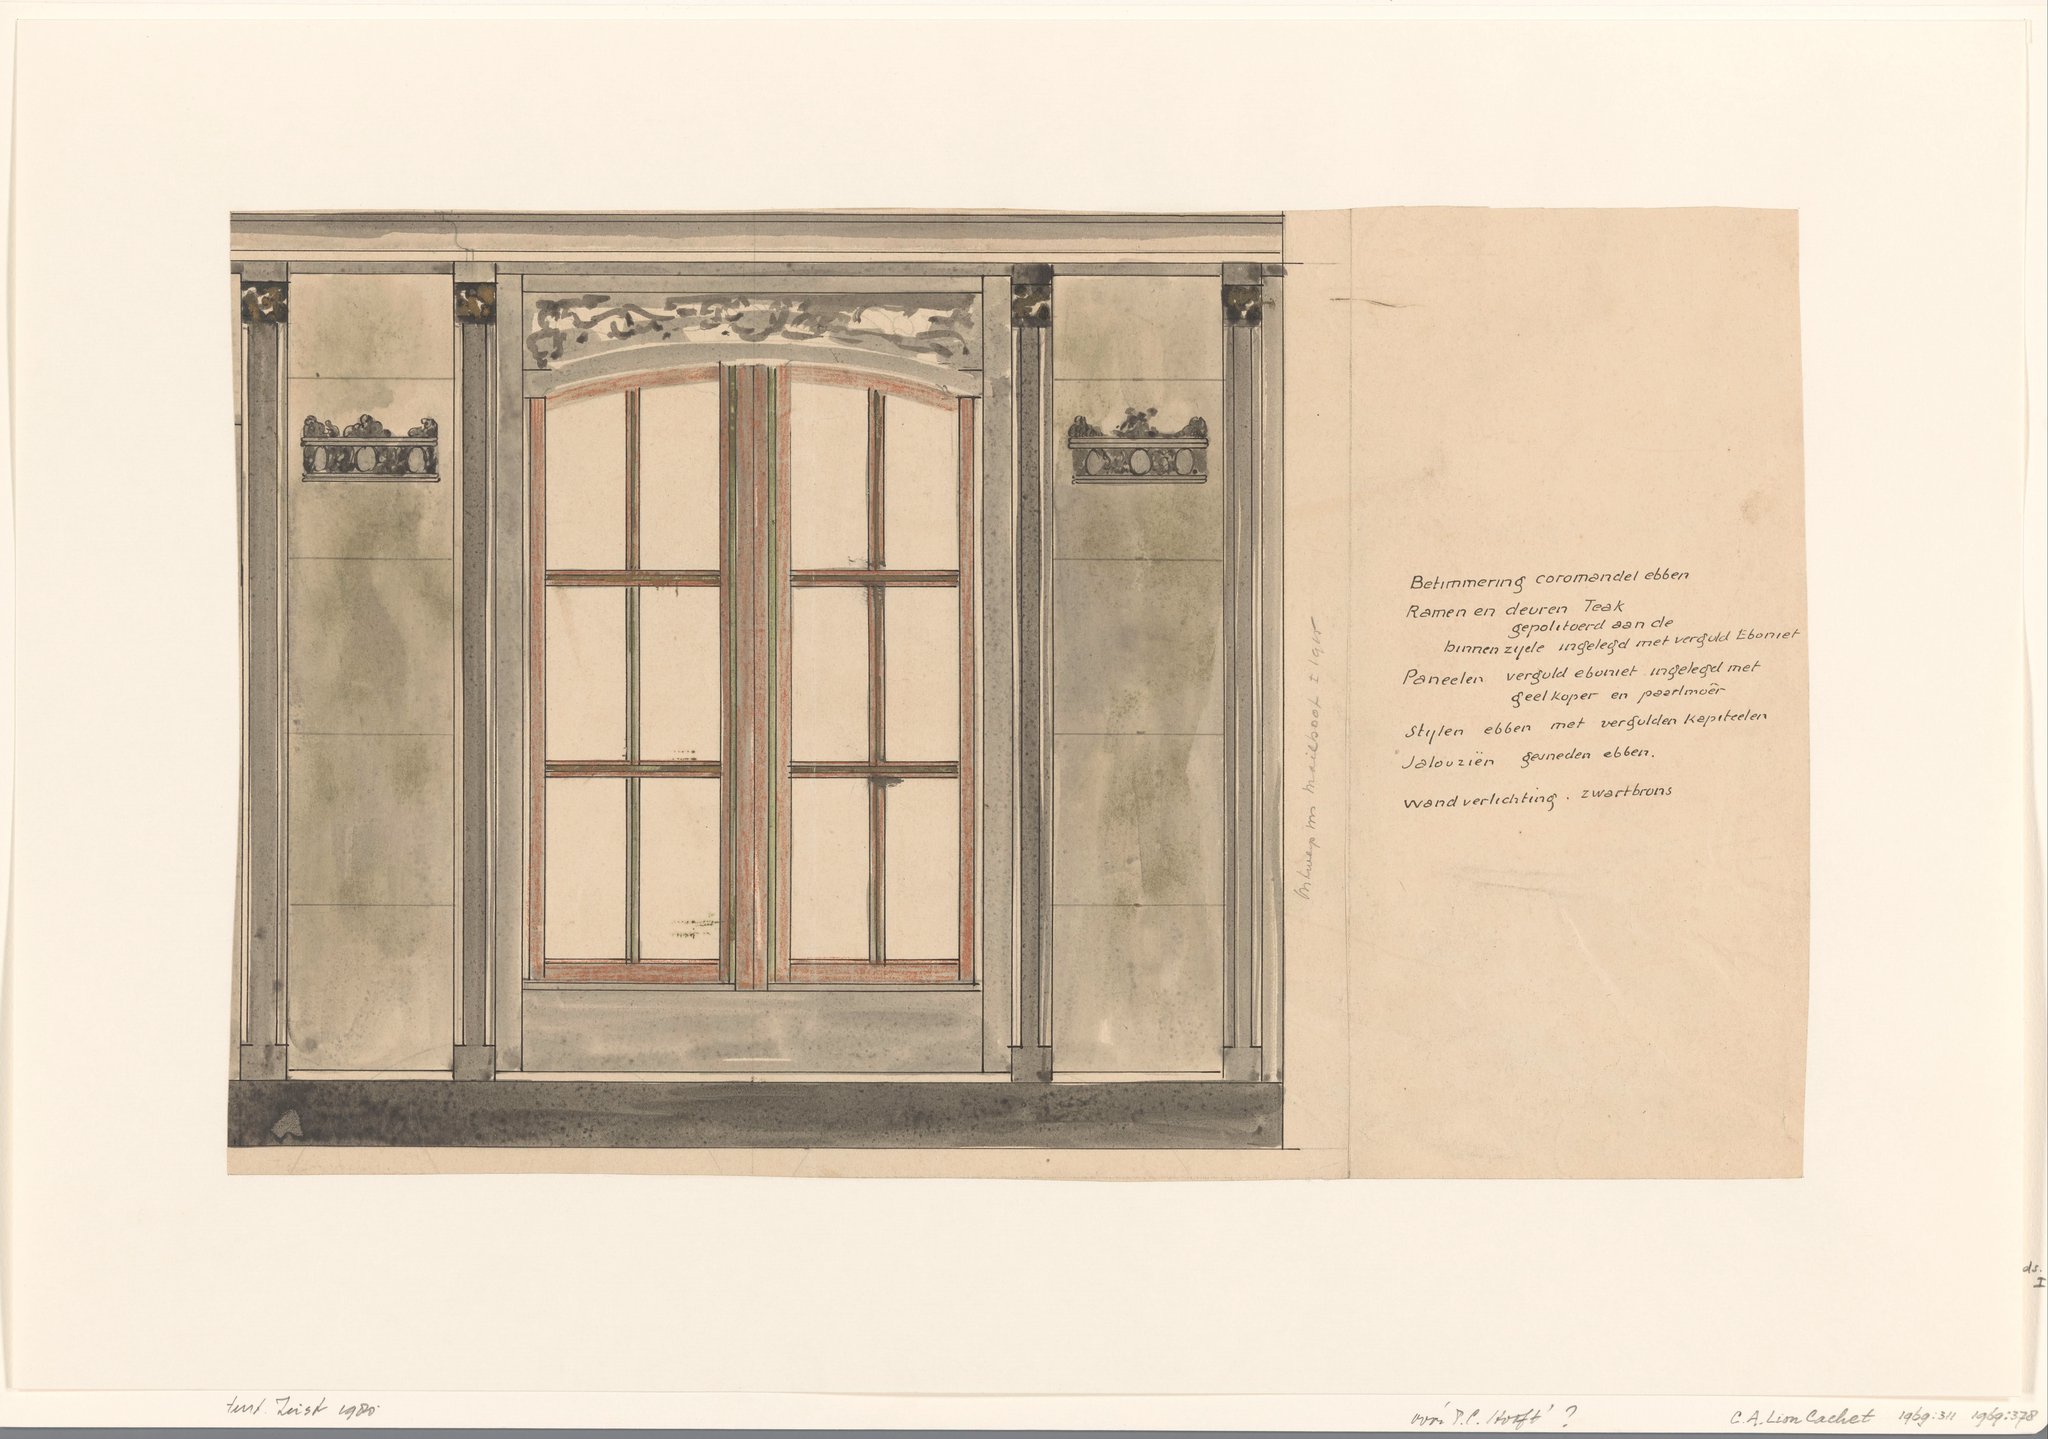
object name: design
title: Ontwerp voor een wand van de mailboot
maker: carel adolph lion cachet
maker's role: draughtsman, print maker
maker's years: 1864-1945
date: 1874-1945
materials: chalk, ink, paper, pencil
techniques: brush, pen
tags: names of artefacts and man-made objects (buildings excluded), ships (in general), door, interior of the house, wall-covering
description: Interieurontwerp voor een wand van de mailboot (met een beschrijving van de betimmering: RP-T-1969-378).